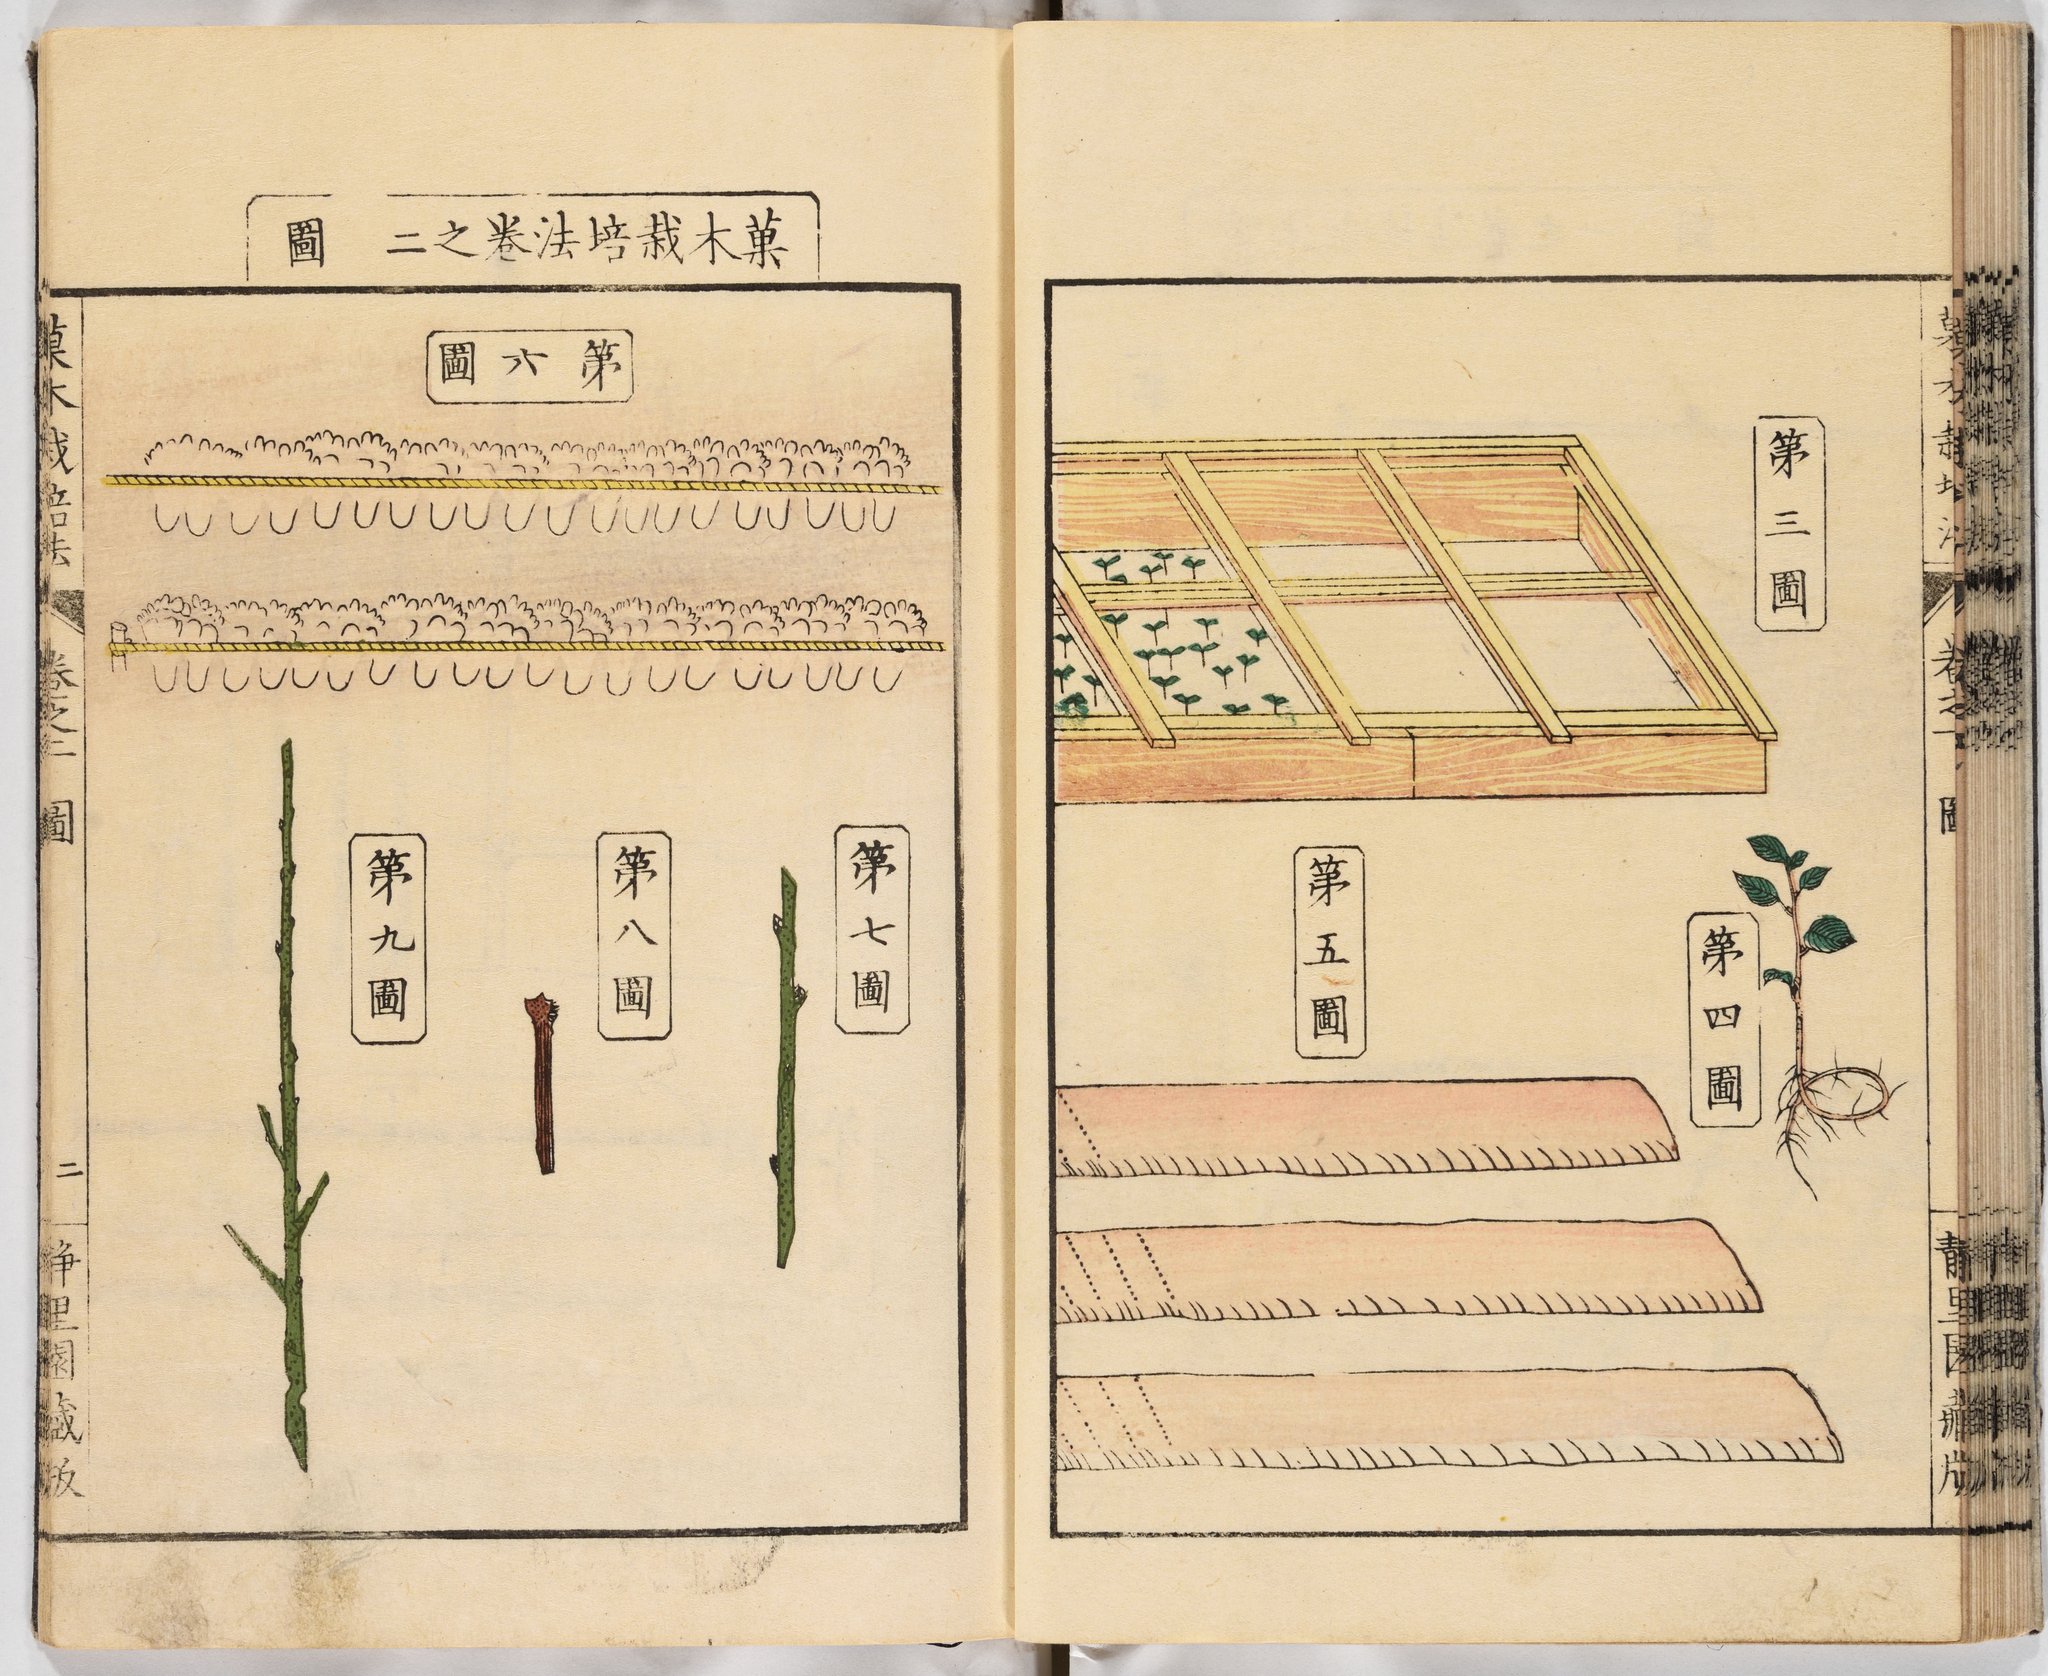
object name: illustrated book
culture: japanese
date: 1893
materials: ink, paper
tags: plants